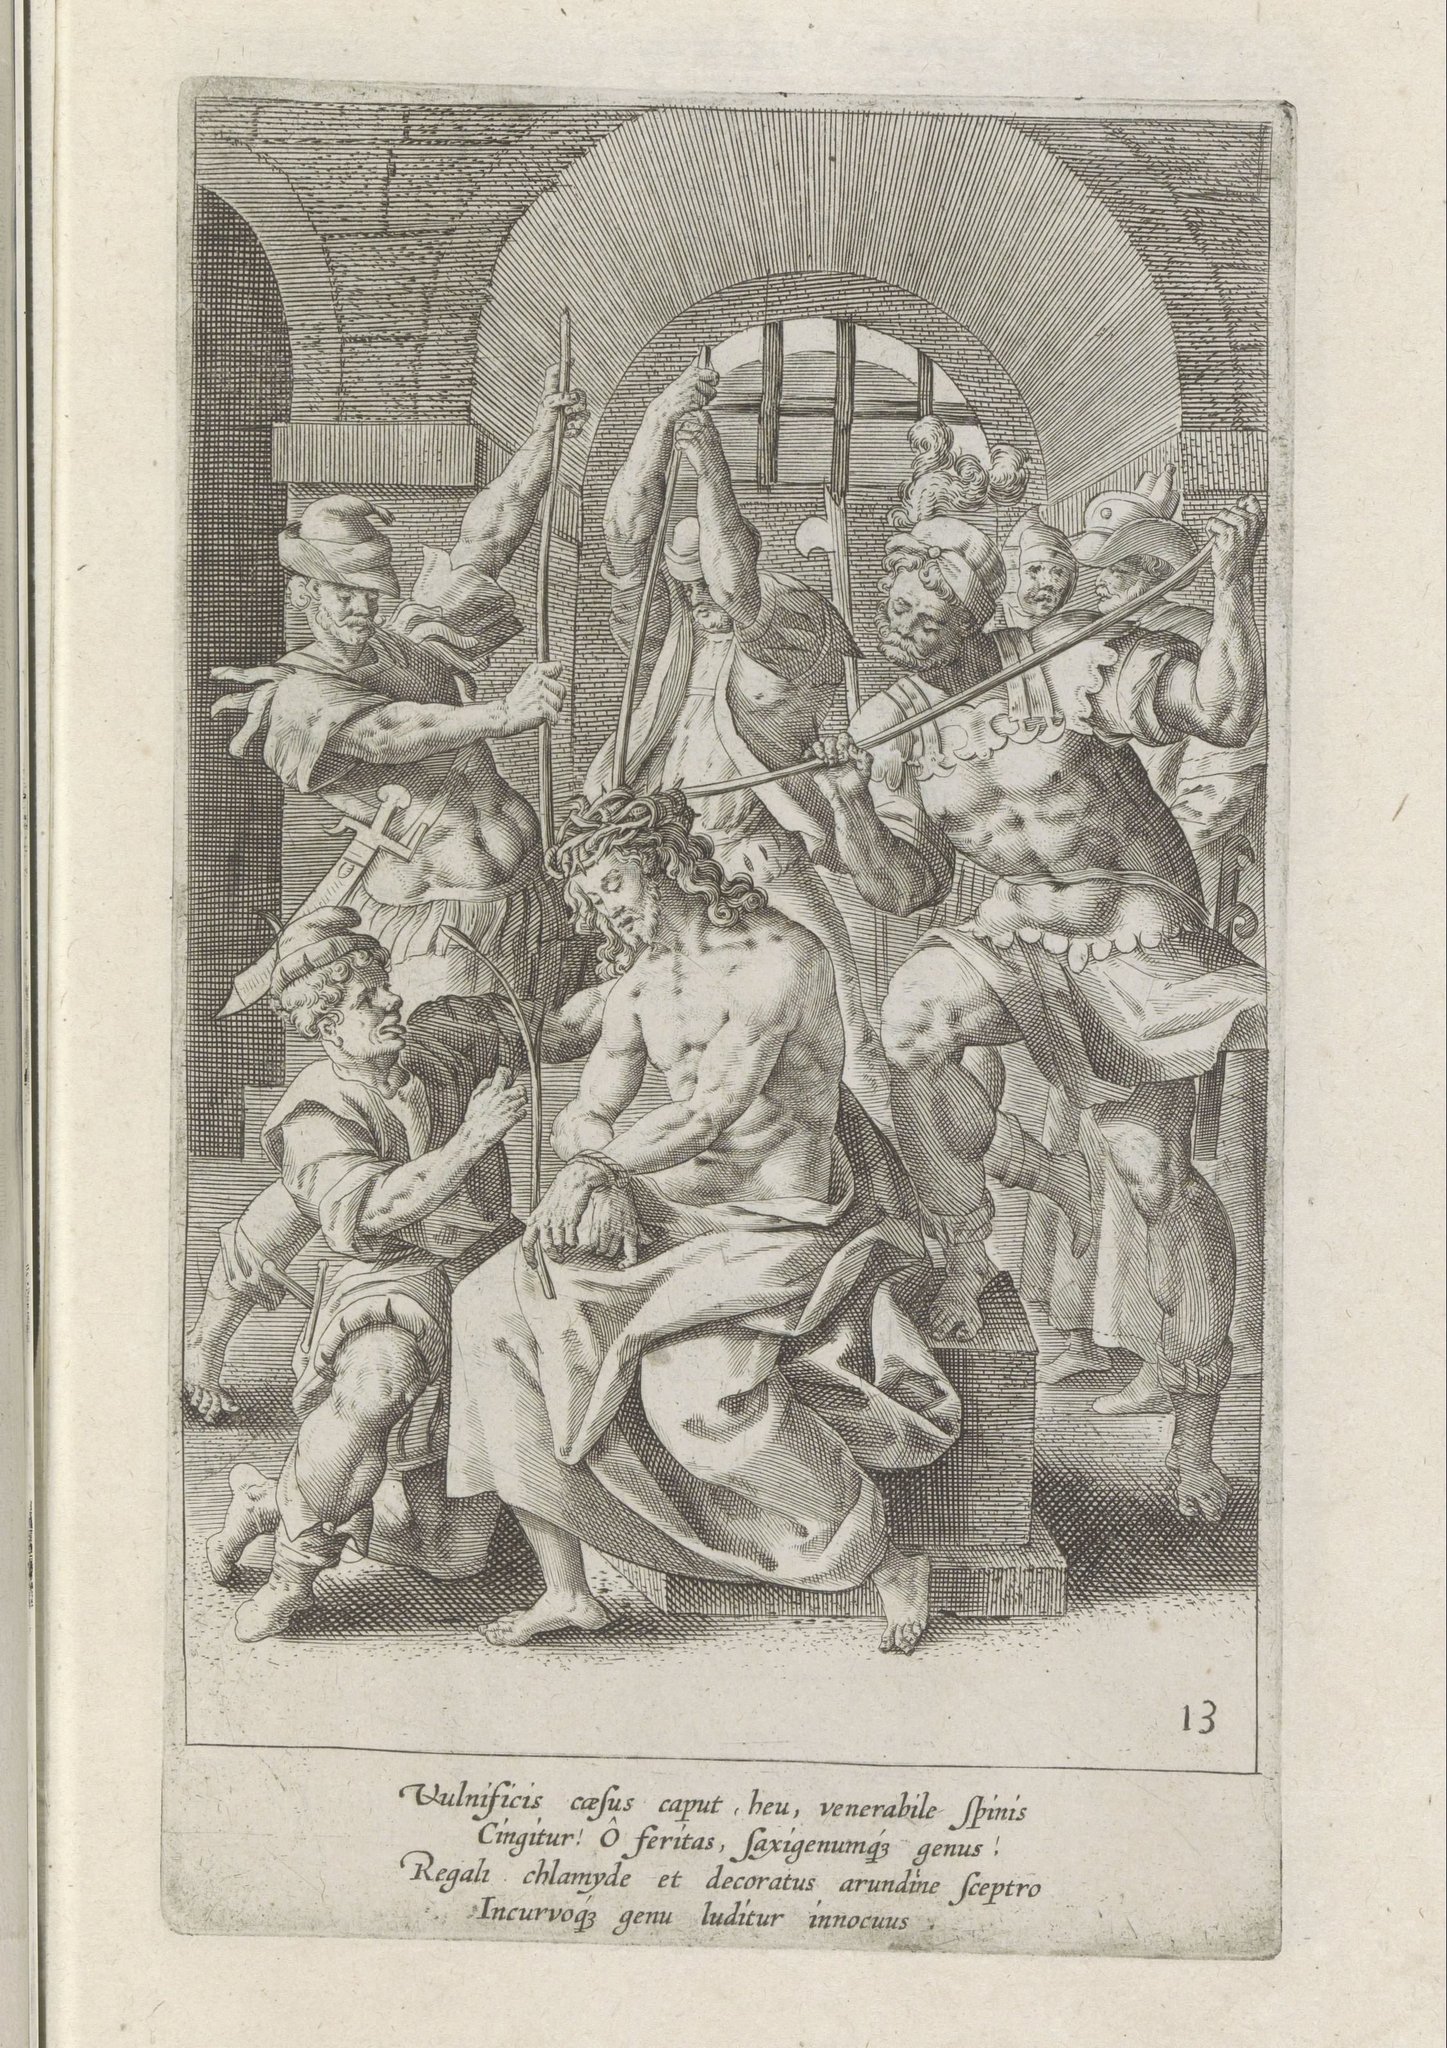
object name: print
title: Leven en passie van Christus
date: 1585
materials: paper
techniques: engraving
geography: antwerp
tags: the crowning with thorns: soldiers with sticks place a thorny crown on christ's head and give him a reed (matthew 27:27-31; mark 15:16-20; john 19:2-3)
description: Soldaten duwen met stokken de doornenkroon op het hoofd van de met touwen geboeide Christus. Een man zit in geknielde houding voor Christus en bespot hem. Onder de voorstelling een vierregelig vers in het Latijn. Deze prent maakt deel uit van een album.